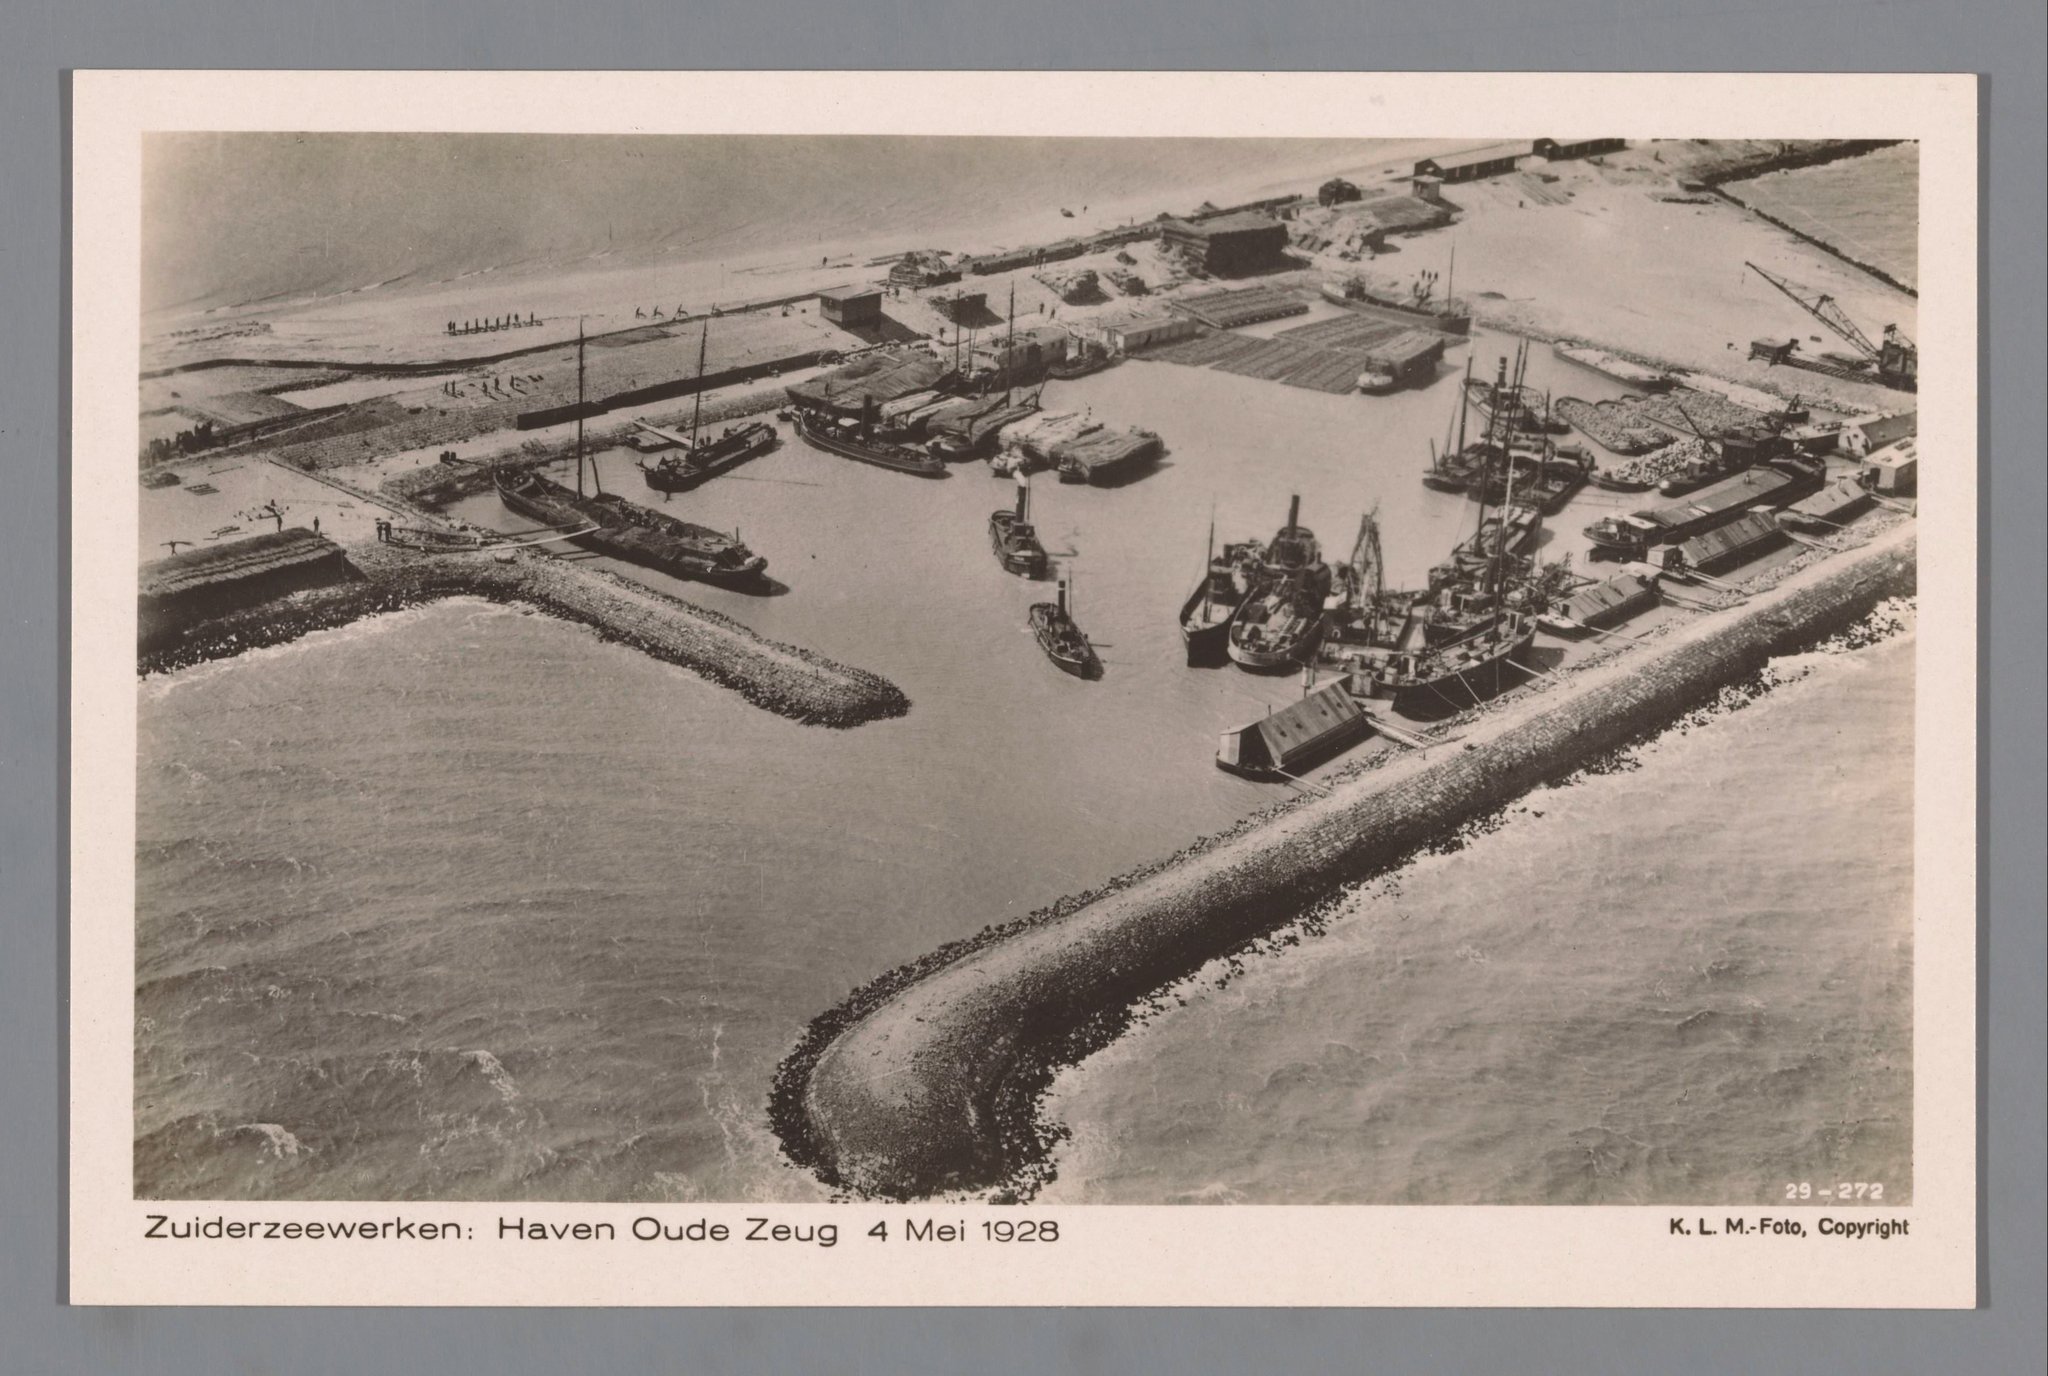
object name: ansichtkaart, prentbriefkaart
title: Zuiderzeewerken: Haven Oude Zeug 4 mei 1928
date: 1928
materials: cardboard, photographic support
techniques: gelatin silver print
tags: harbour, zuiderzee